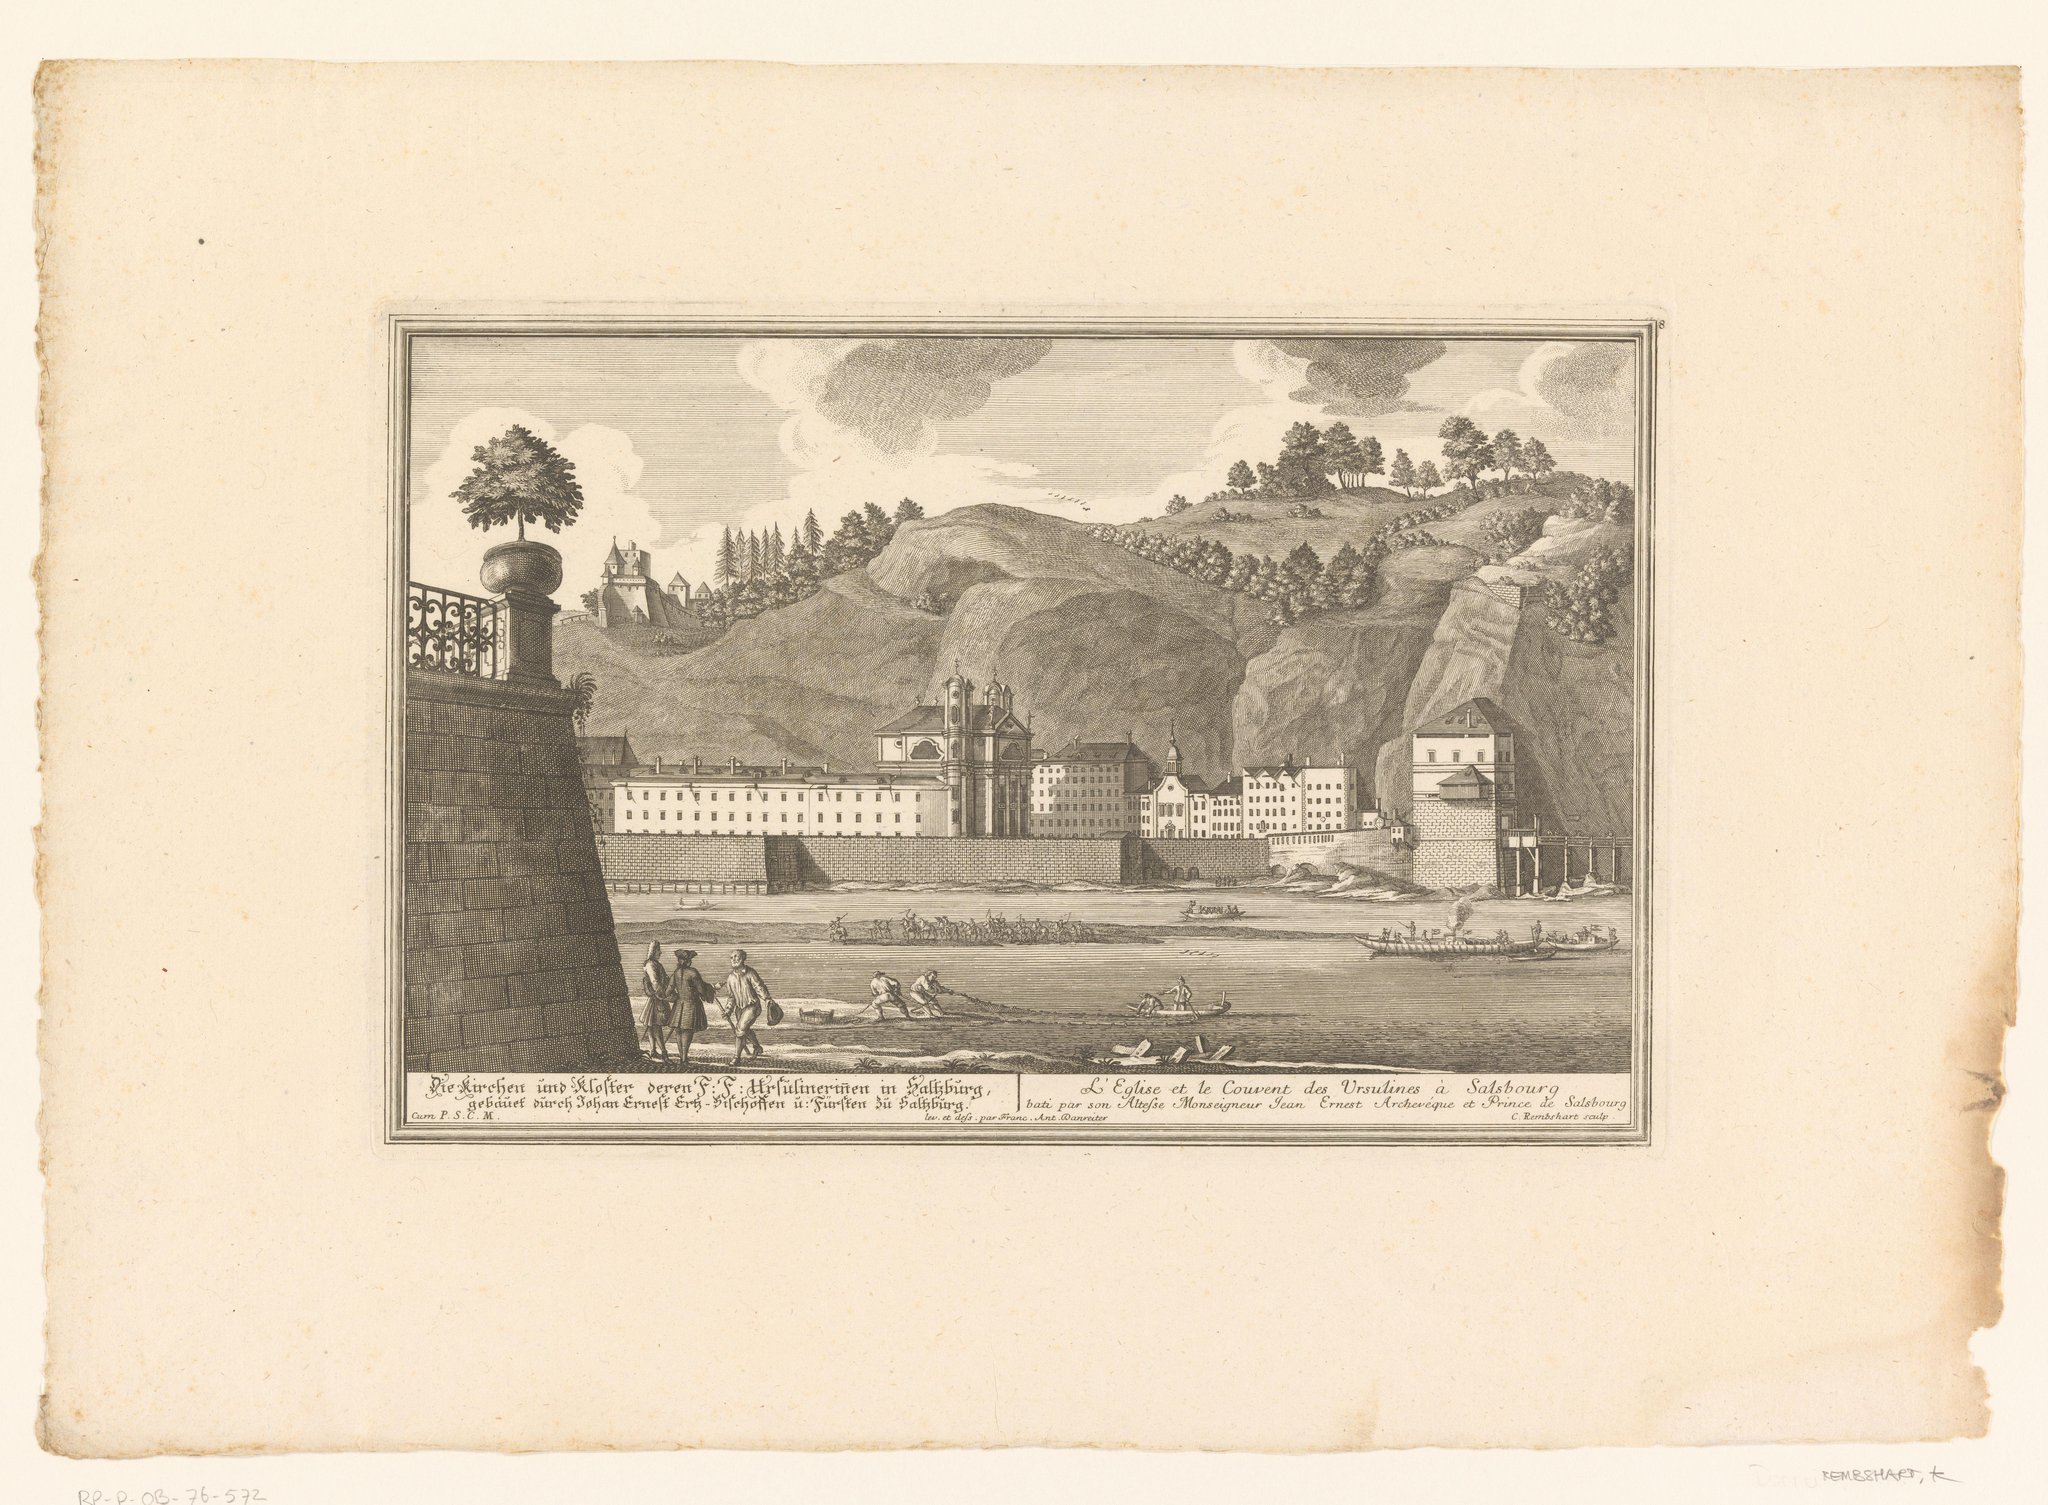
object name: ornament print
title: Ursulinenkerk en -klooster in Salzburg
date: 1730-1740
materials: paper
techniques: engraving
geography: augsburg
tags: abbey, monastery, convent ~ roman catholic church, parts of church exterior and annexes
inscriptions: collector's mark: Lugt 2228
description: Ursulinenkerk en -klooster in Salzburg gezien vanaf de oever van de rivier de Salzach.